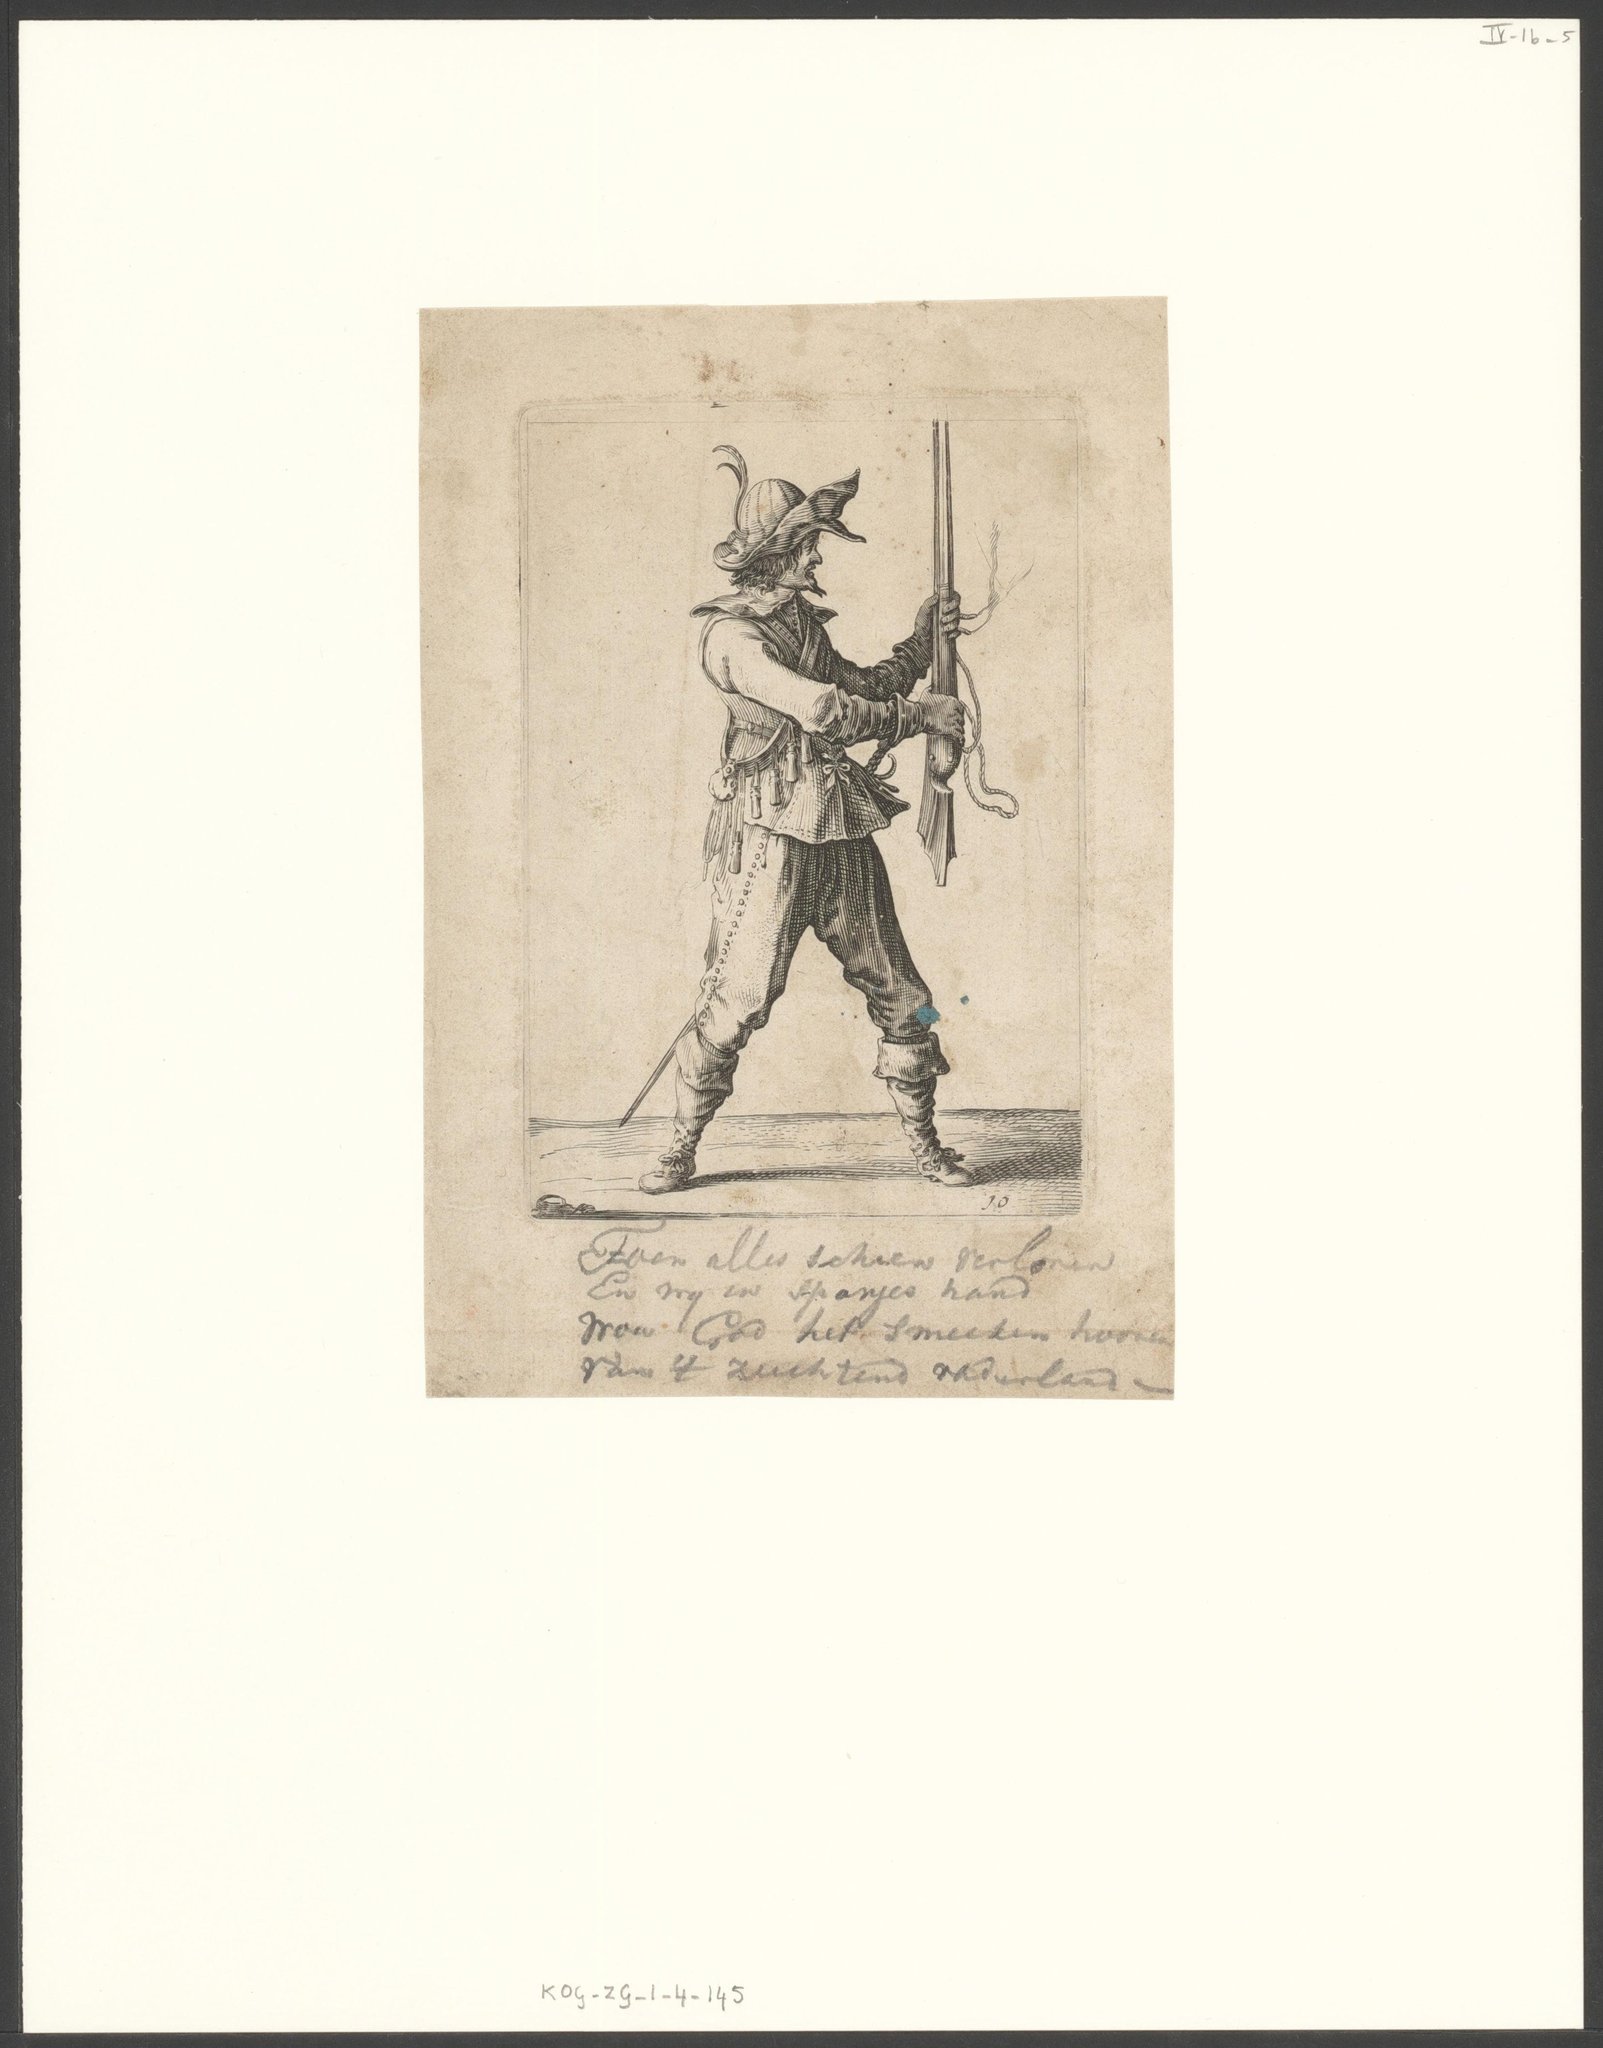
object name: print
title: Staande soldaat met musket in beide handen, naar rechts gedraaid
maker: salomon savery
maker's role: print maker, publisher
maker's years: 1594-1683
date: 1630-1665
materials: paper, pencil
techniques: engraving, etching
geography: amsterdam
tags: handling of weapons ~ military training (+ infantry), clothes, costume (+ men's clothes), (military) uniforms